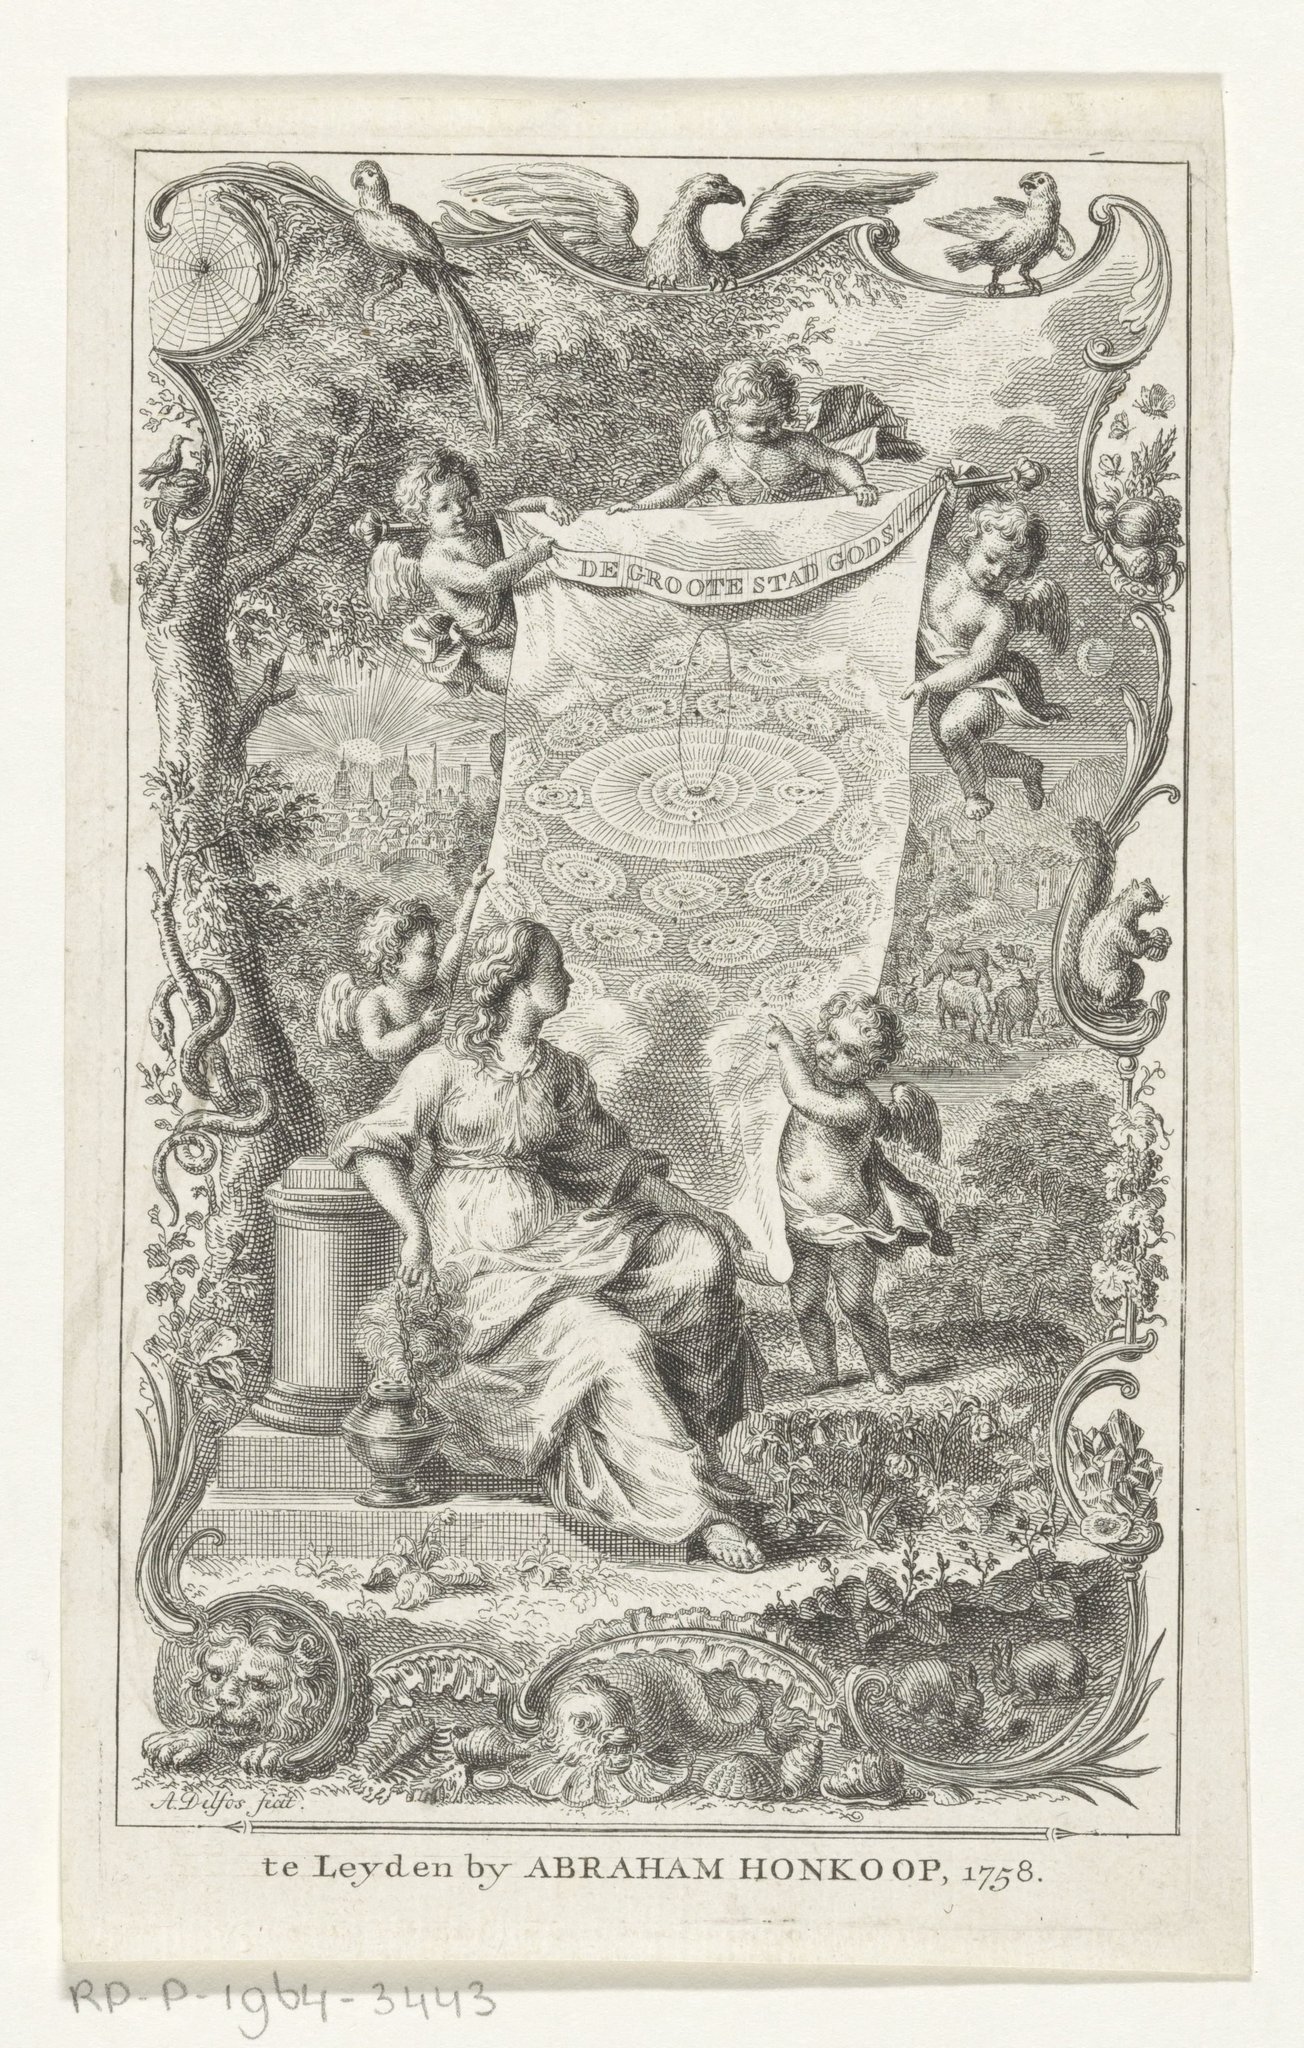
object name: titelblad, titelpagina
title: De groote stad Gods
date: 1758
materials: paper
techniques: etching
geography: leiden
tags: the new jerusalem, the all-seeing eye, triangle with eye ~ symbol of god the father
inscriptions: collector's mark: Lugt 2760, collector's mark: Lugt 2228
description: Een vrouwelijke personificatie met wierookvat zittend bij een afbeelding van De Groote stad Gods, vastgehouden door putti. Op de achtergrond het silhouet van de stad Jeruzalem. Rondom een omlijsting met dieren zoals een leeuw, slang, eekhoorn en vogels.